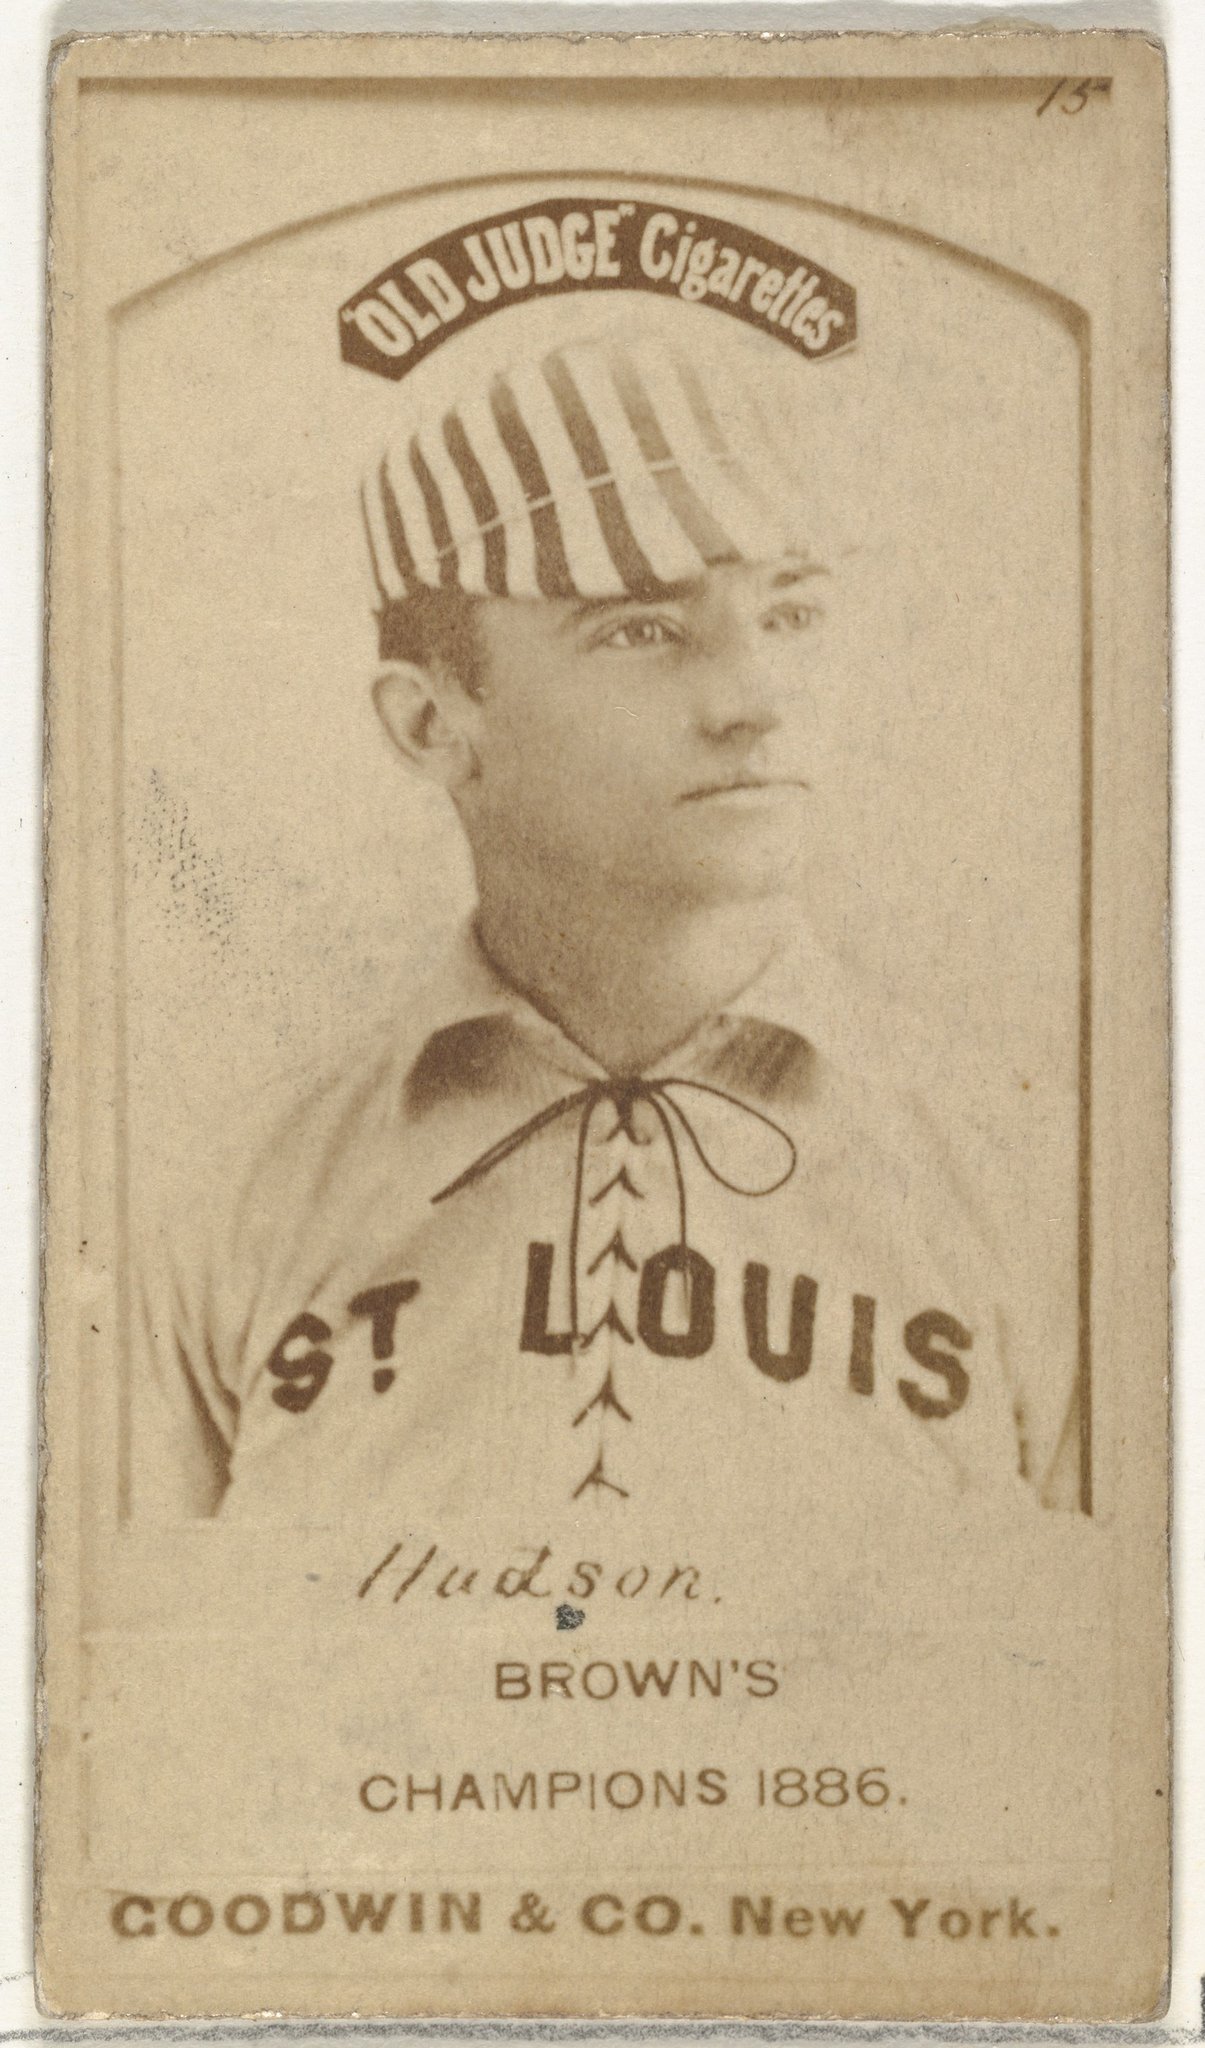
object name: baseball card, photograph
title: Nathaniel P. "Nat" Hudson, Pitcher, St. Louis Browns, from the Old Judge series (N172) for Old Judge Cigarettes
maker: goodwin & company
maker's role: publisher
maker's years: 1850-1950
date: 1886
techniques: albumen silver print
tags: men,portraits,baseball,athletes